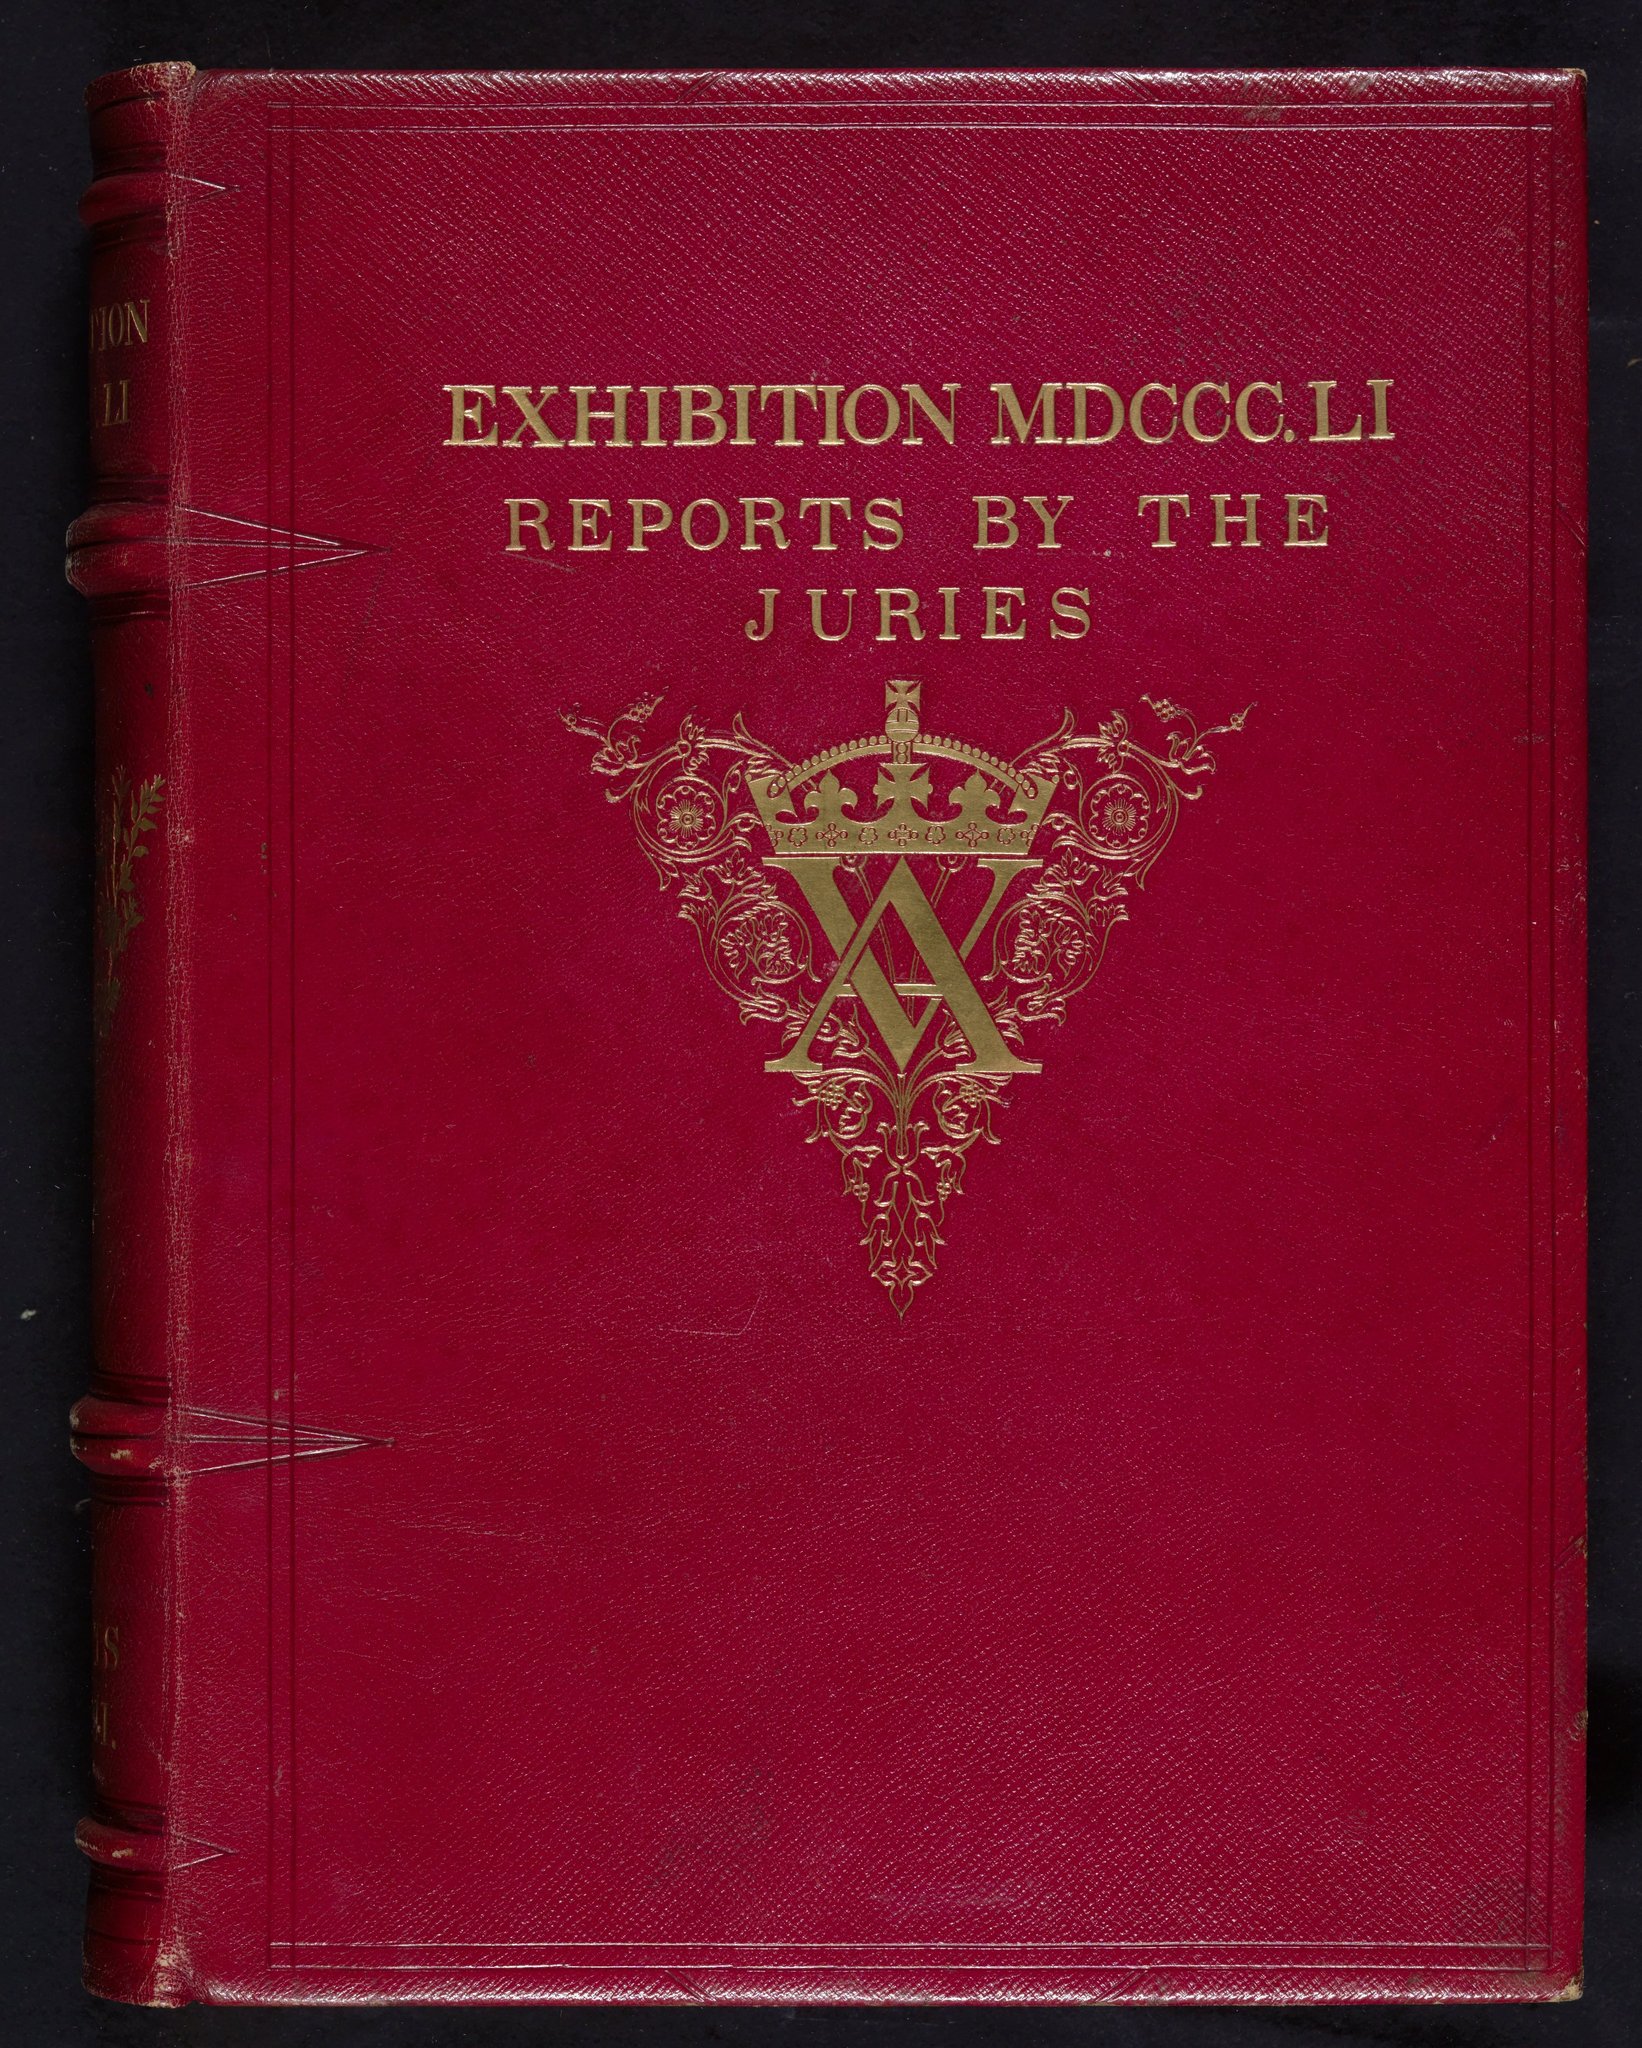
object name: book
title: Exhibition of the works of industry of all nations 1851 : reports by the juries on the subjects in the thirty classes into which the exhibition was divided Vol. II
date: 1852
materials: leather, paper, photographic support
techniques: salted paper print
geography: london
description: It took many months before all 21,000 impressions were made (by hand!) that filled the 137 copies of these jury reports. The slow pace was caused not only by the fact that every step of the process had to be done by hand, but also because it depended on sunlight, which was not always sufficiently present.